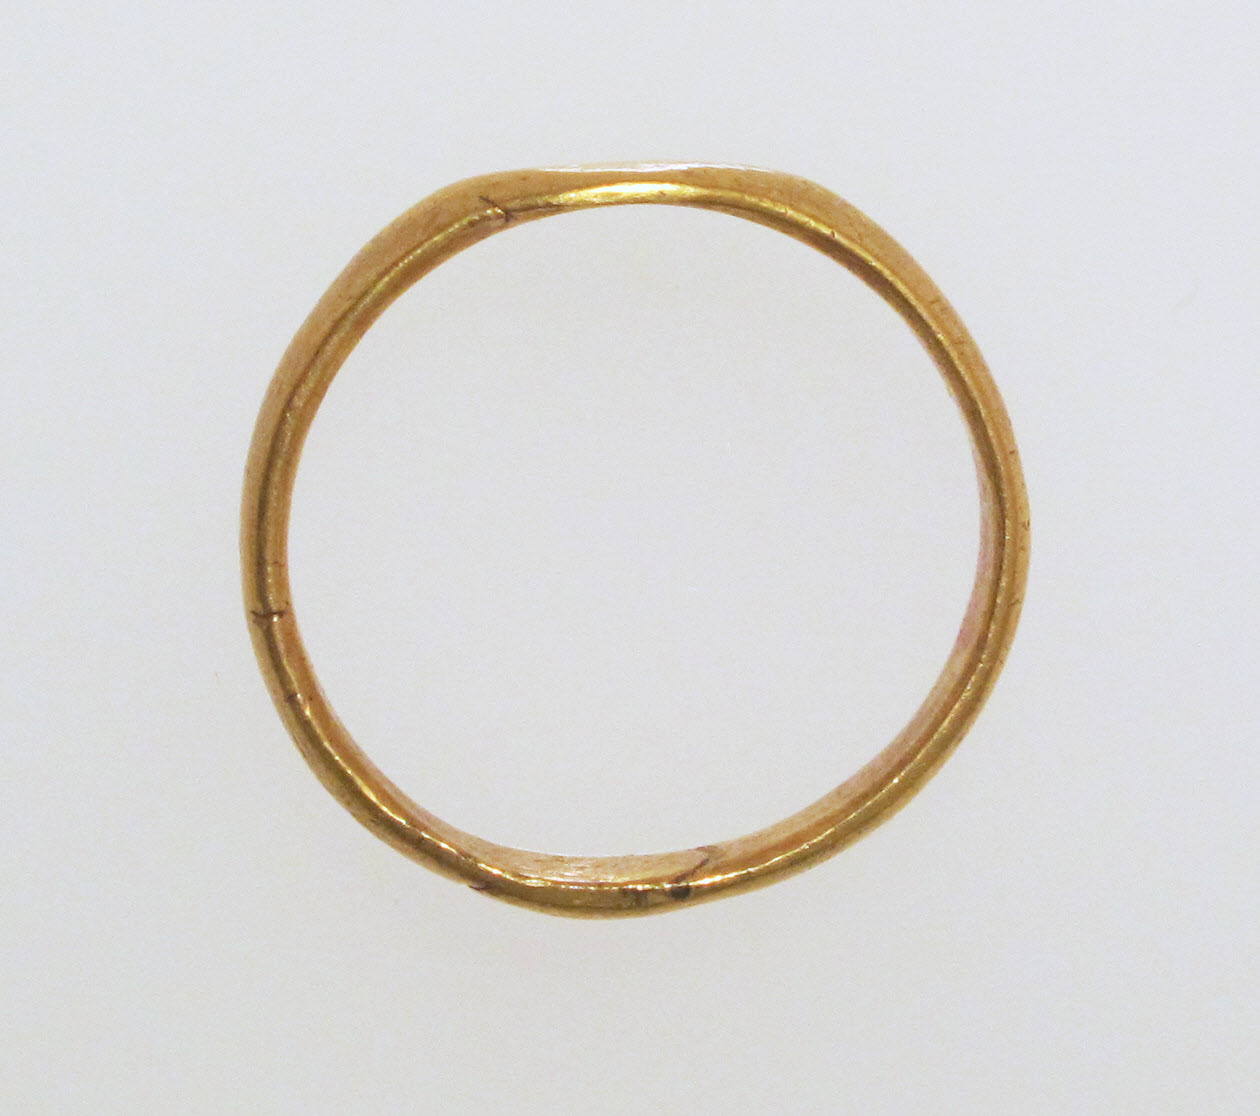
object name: ring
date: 7000 BCE-330 CE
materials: gold